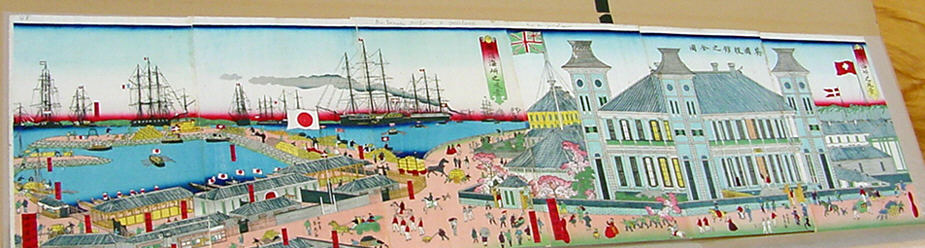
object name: print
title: View of the Seafront at Yokohama and the British Trading House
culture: japanese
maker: utagawa (gountei) sadahide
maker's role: artist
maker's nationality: japanese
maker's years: 1807-1873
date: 1869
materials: ink, paper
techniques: woodblock print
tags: human figures,houses,horses,ships